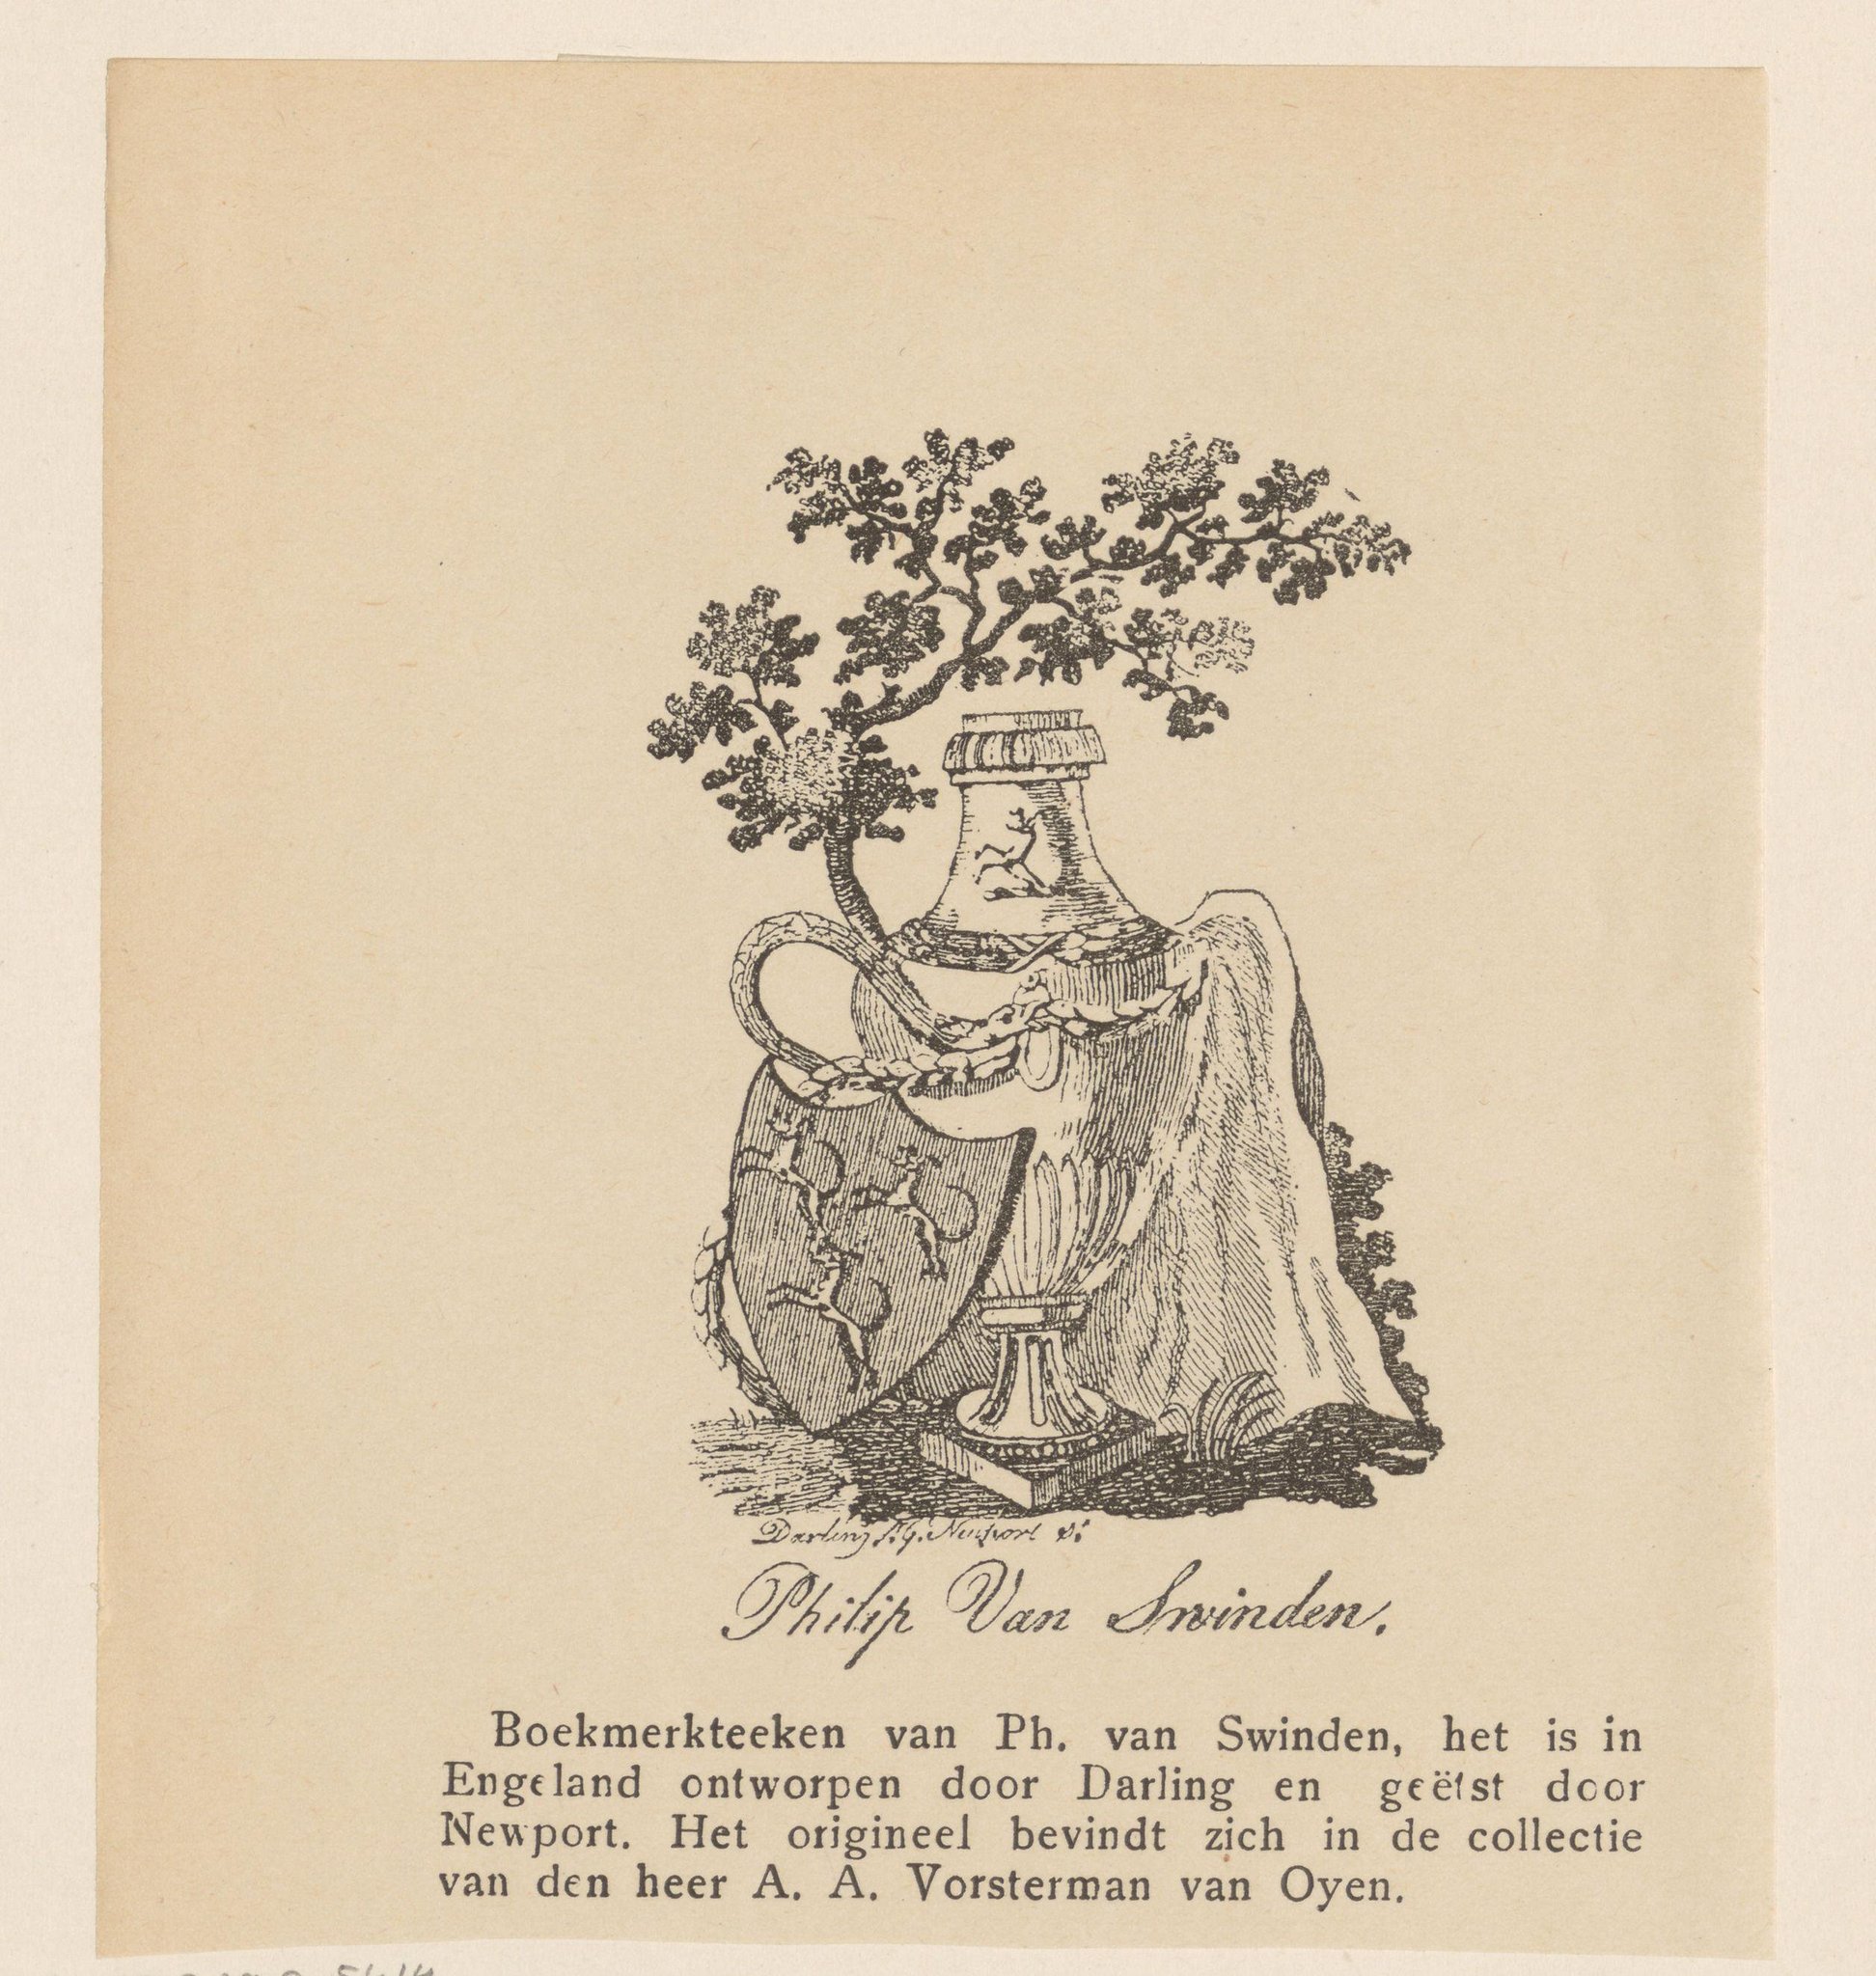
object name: bookplate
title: Ex libris van Philip van Swinden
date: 1750-1849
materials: paper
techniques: letterpress printing, printing block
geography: england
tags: trees, container of ceramics: jar, jug, pot, vase, armorial bearing, heraldry, dog